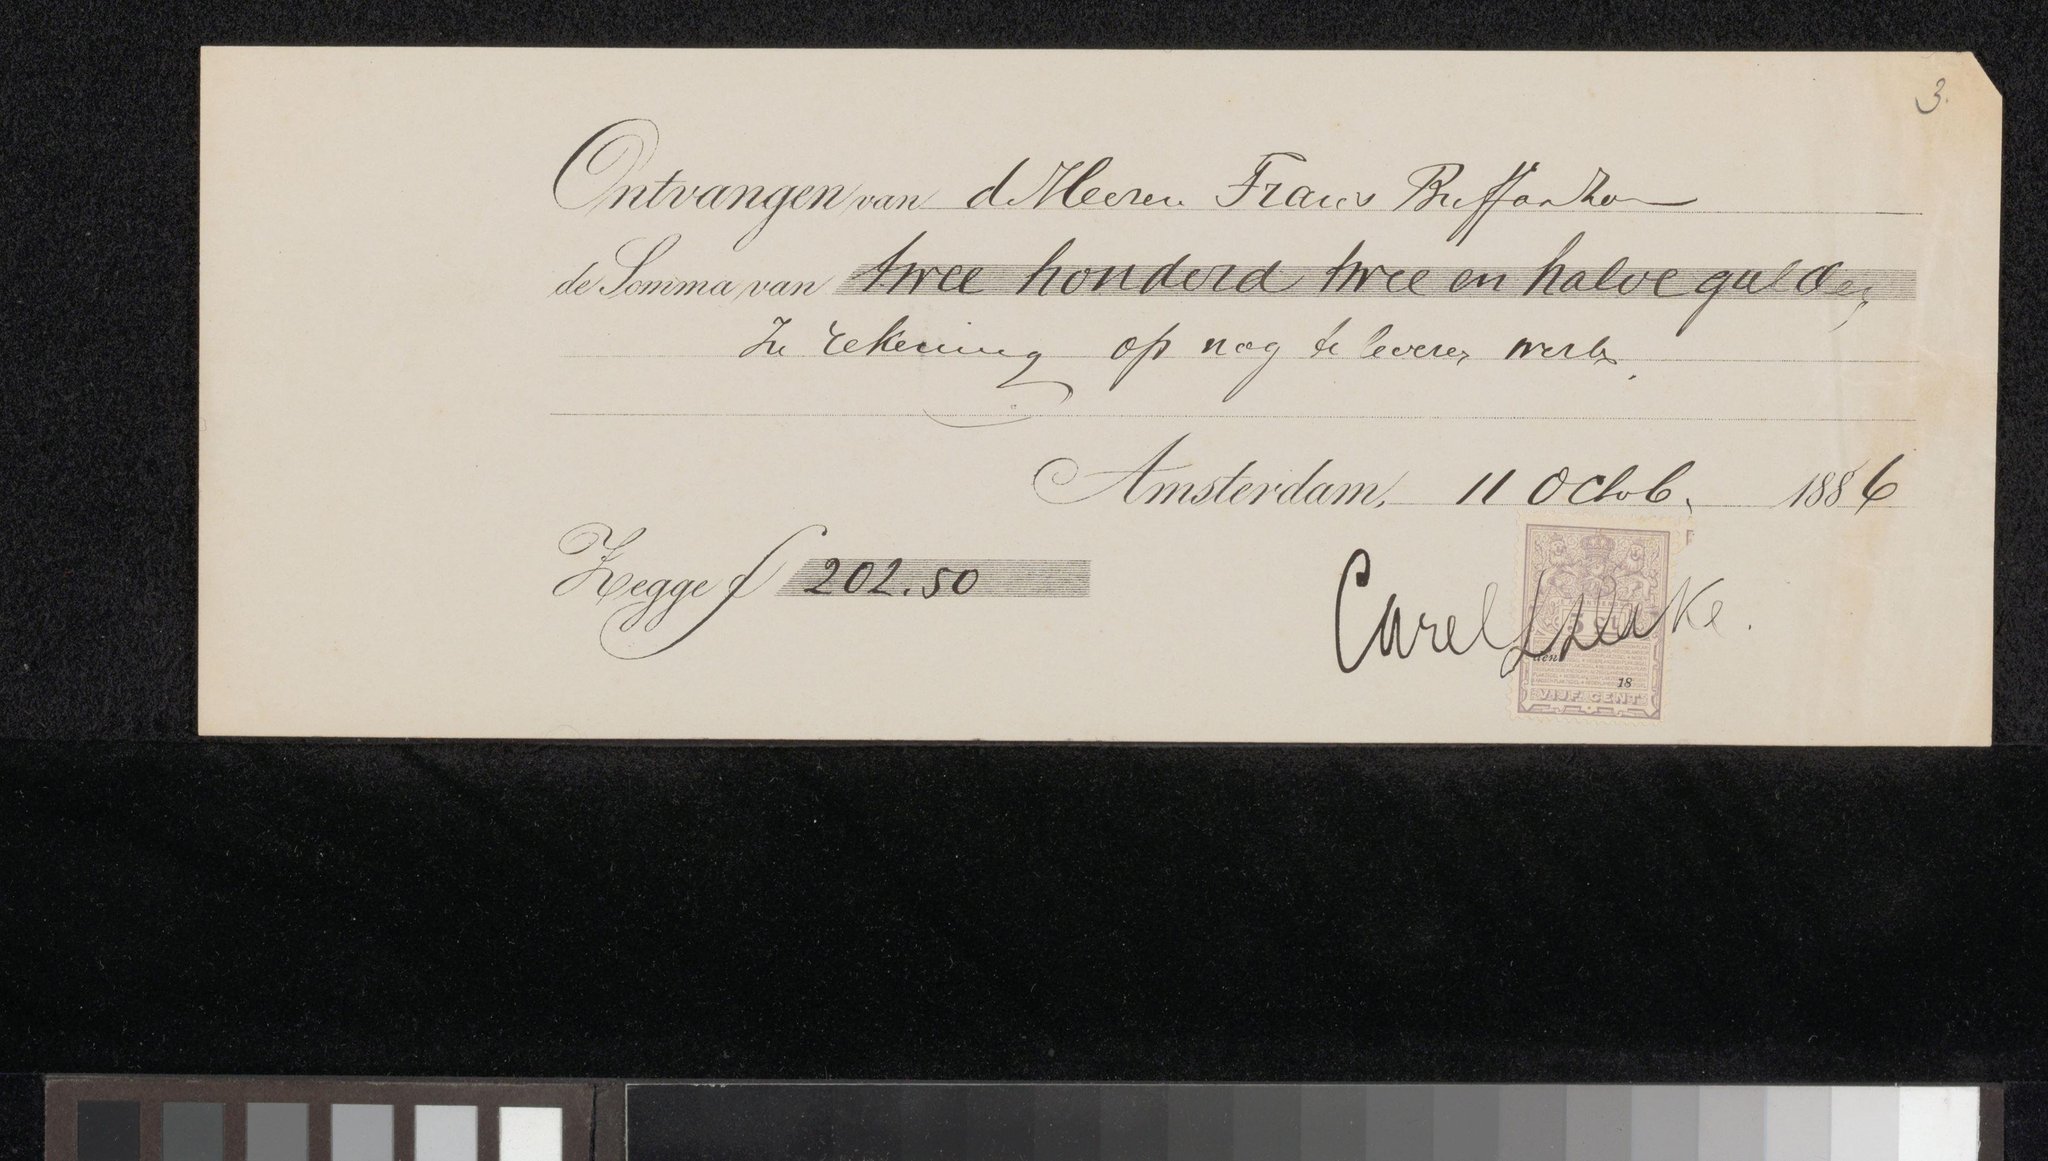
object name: ontvangstbewijs, kwitantie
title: Kwitantie voor Carel Lodewijk Dake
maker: carel lodewijk dake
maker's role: draughtsman, painter, print maker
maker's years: 1857-1918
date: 1886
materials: ink, paper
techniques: pen, printing, writing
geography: amsterdam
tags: amsterdam, painter, print maker, draughtsman, carel lodewijk dake, money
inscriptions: collector's mark: Lugt 2233